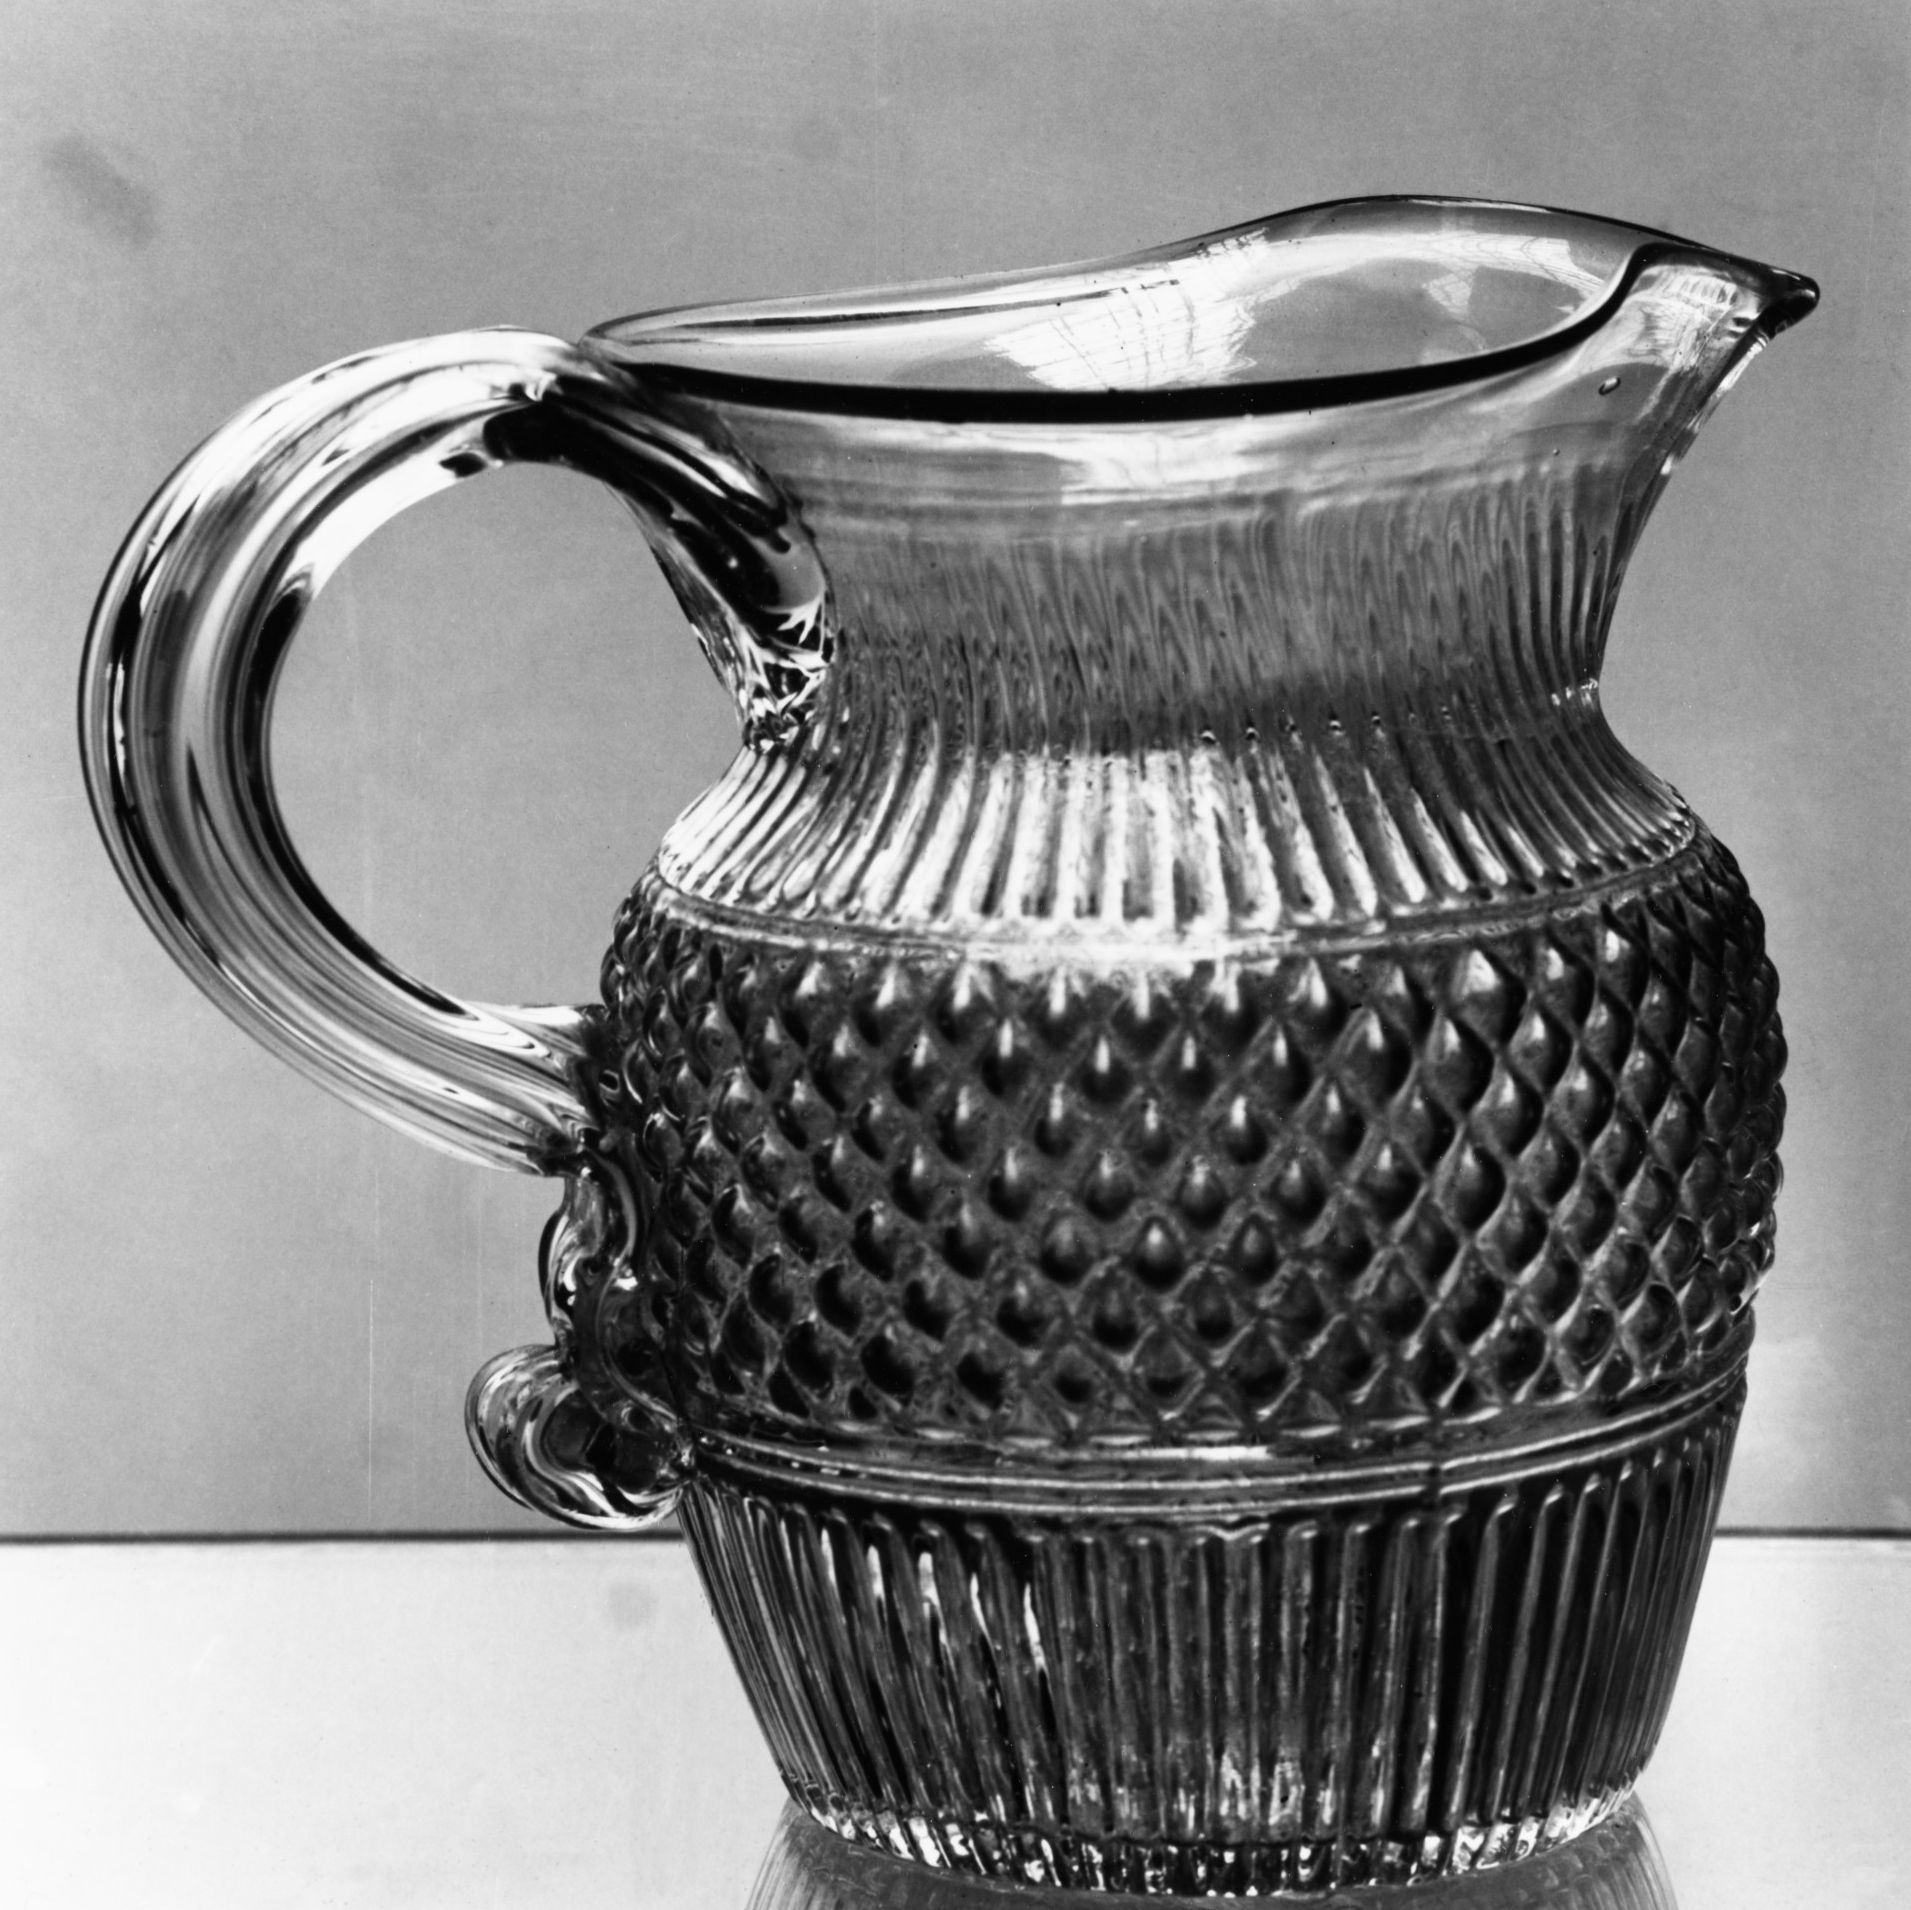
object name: jug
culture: american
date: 1820-1840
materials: glass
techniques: glassblowing, molding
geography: united states